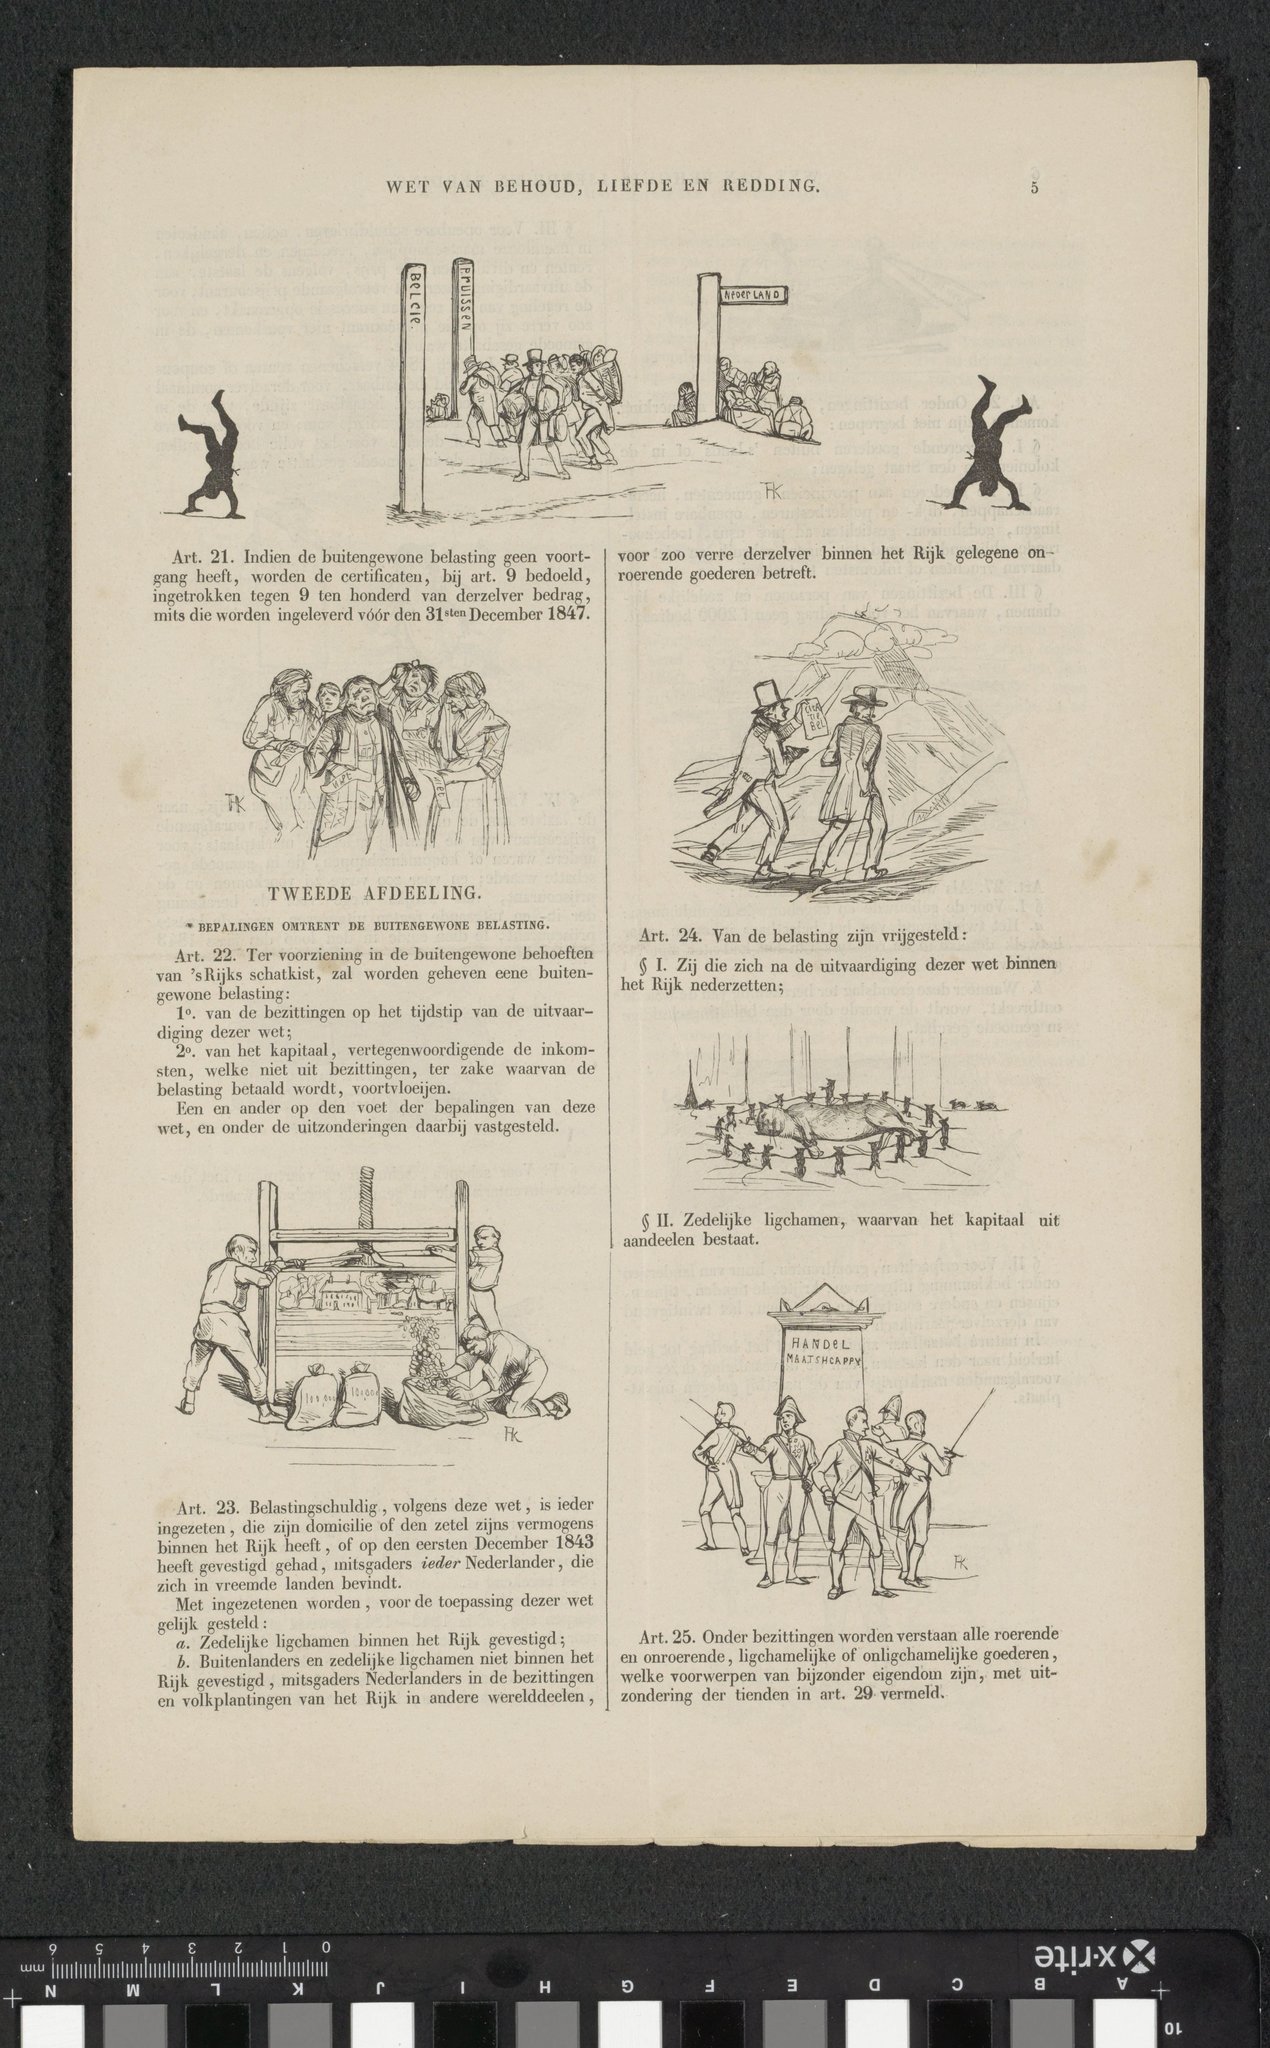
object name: print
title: Satire op de aansporing tot deelneming in de (zogenaamde) vrijwillige 3% geldlening van 1844 (blad 5)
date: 1844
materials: paper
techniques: letterpress printing, engraving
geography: the hague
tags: the hague, floris adriaan van hall, organization of trade and finance, taxes and financial administration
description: Bladzijde 5 met artikels 21-25 van de 'Wet van Behoud, Liefde en Redding'. Een satire in zestien bladzijden op de aansporing tot deelneming in de (zogenaamde) vrijwillige 3% geldlening uitgeschreven in maart 1844 door minister F. A. van Hall. Voorzijde van een dubbelgevouwen blad bedrukt op alle zijden.